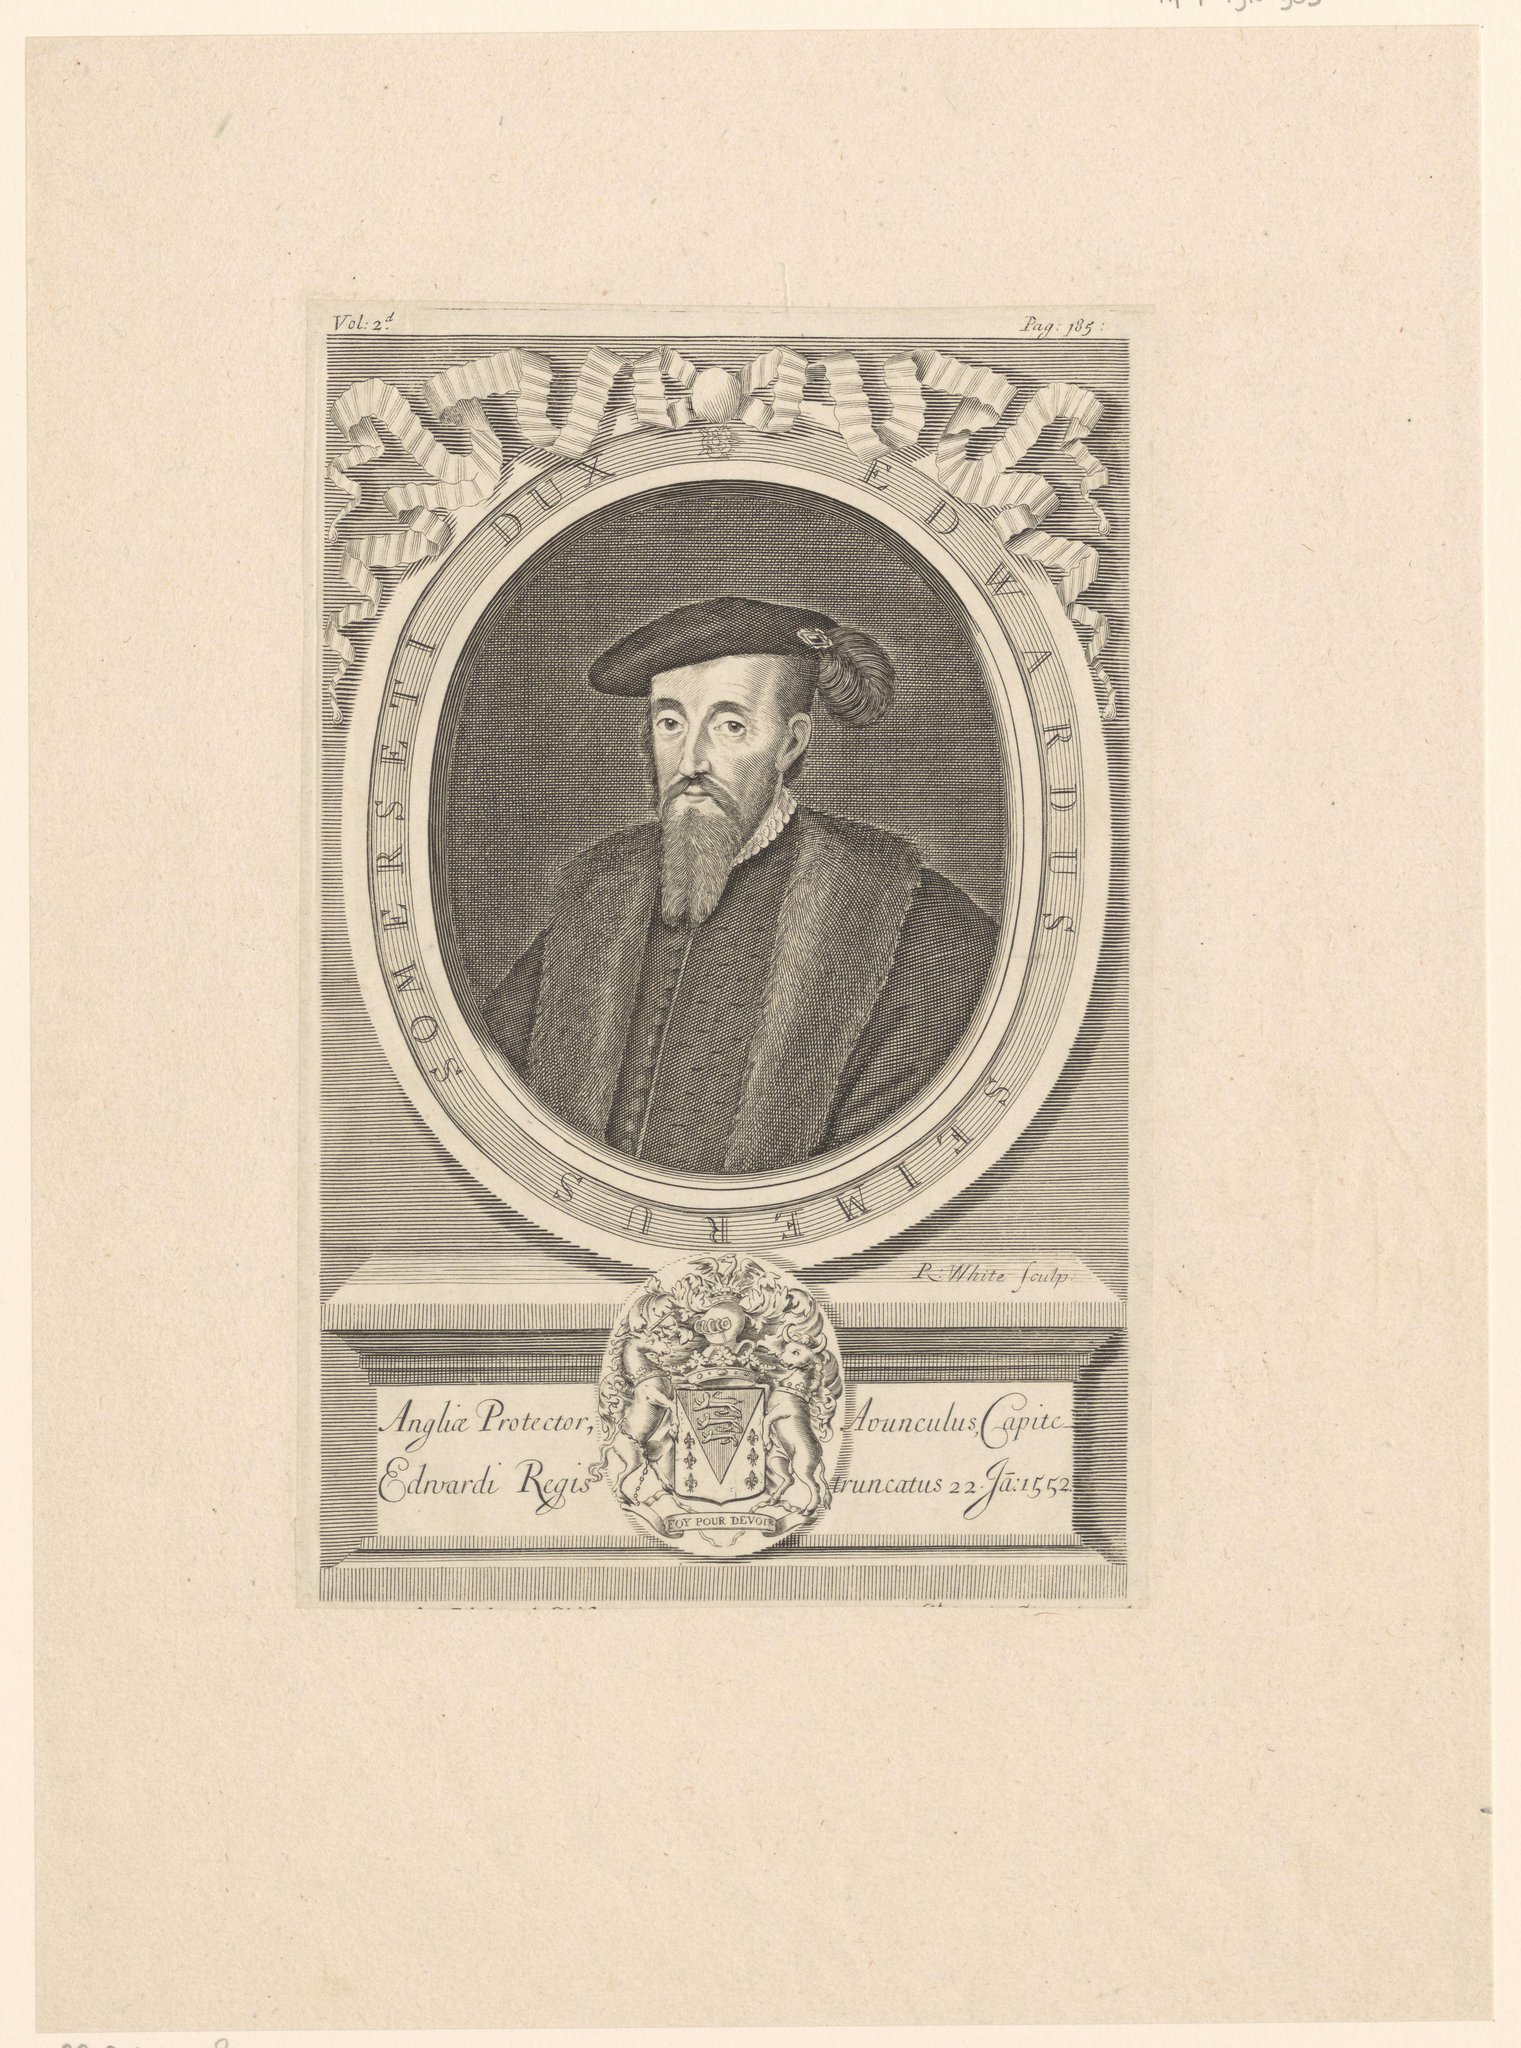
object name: book illustration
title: Edwardus Seimerus Somerseti Dux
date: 1681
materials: paper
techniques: engraving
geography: london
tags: historical persons, other sovereign (with title)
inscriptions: collector's mark: Lugt 2228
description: Prent uit: Burnet, Gilbert. The History of the Reformation of the Church of England. Londen: Richard Chiswell, 1681, dl. 2, p. 185.